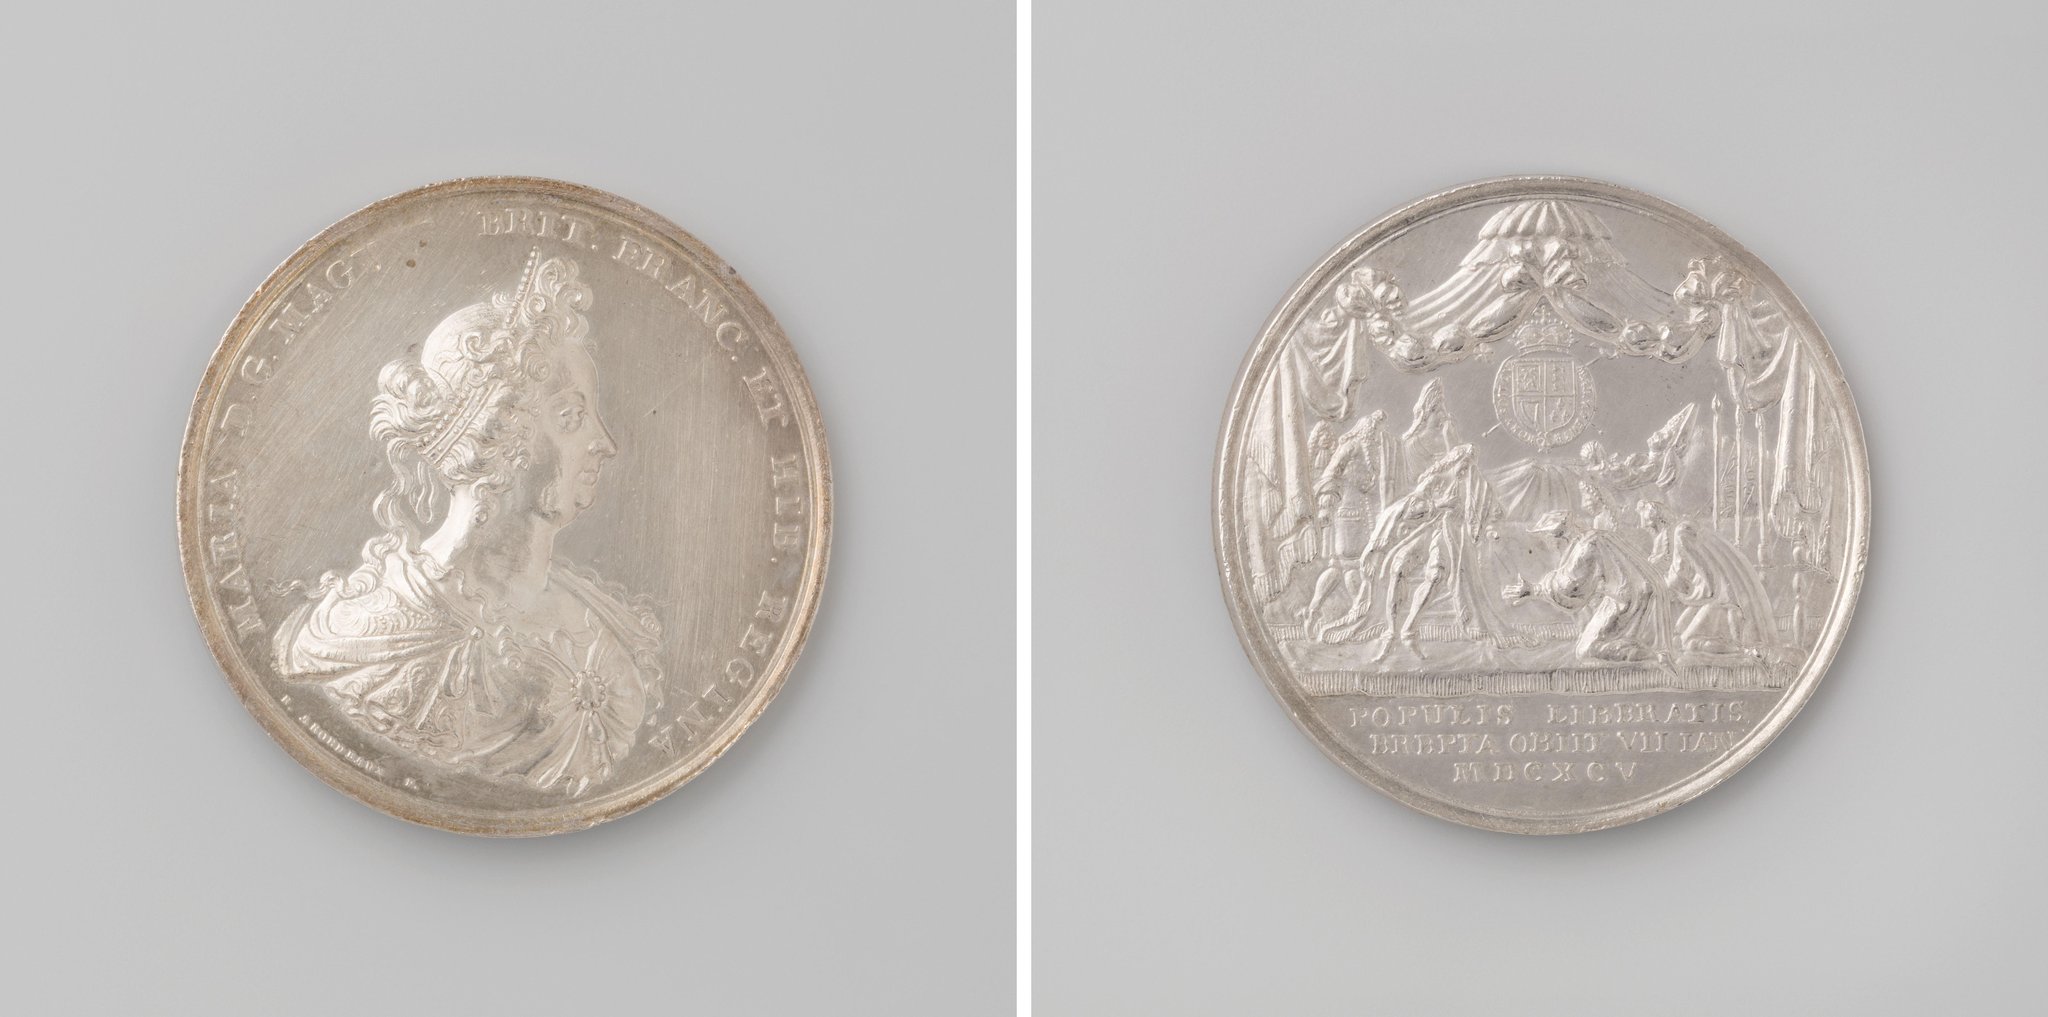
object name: history medal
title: Overlijden van Maria II van Engeland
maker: reynier arondeaux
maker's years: 1678-1727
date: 1695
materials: silver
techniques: striking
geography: amsterdam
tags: the hague, william iii (prince of orange and king of england, scotland, and ireland), london, maria ii stuart (koningin van engeland, schotland en ierland)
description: Zilveren penning. Voorzijde: borststuk vrouw met kroon binnen omschrift. Keerzijde: overledene opgebaard op bed, aan voet rouwende koning met gevolg, voor bed knielende bisschop en twee edelen; afsnede: opschrift.